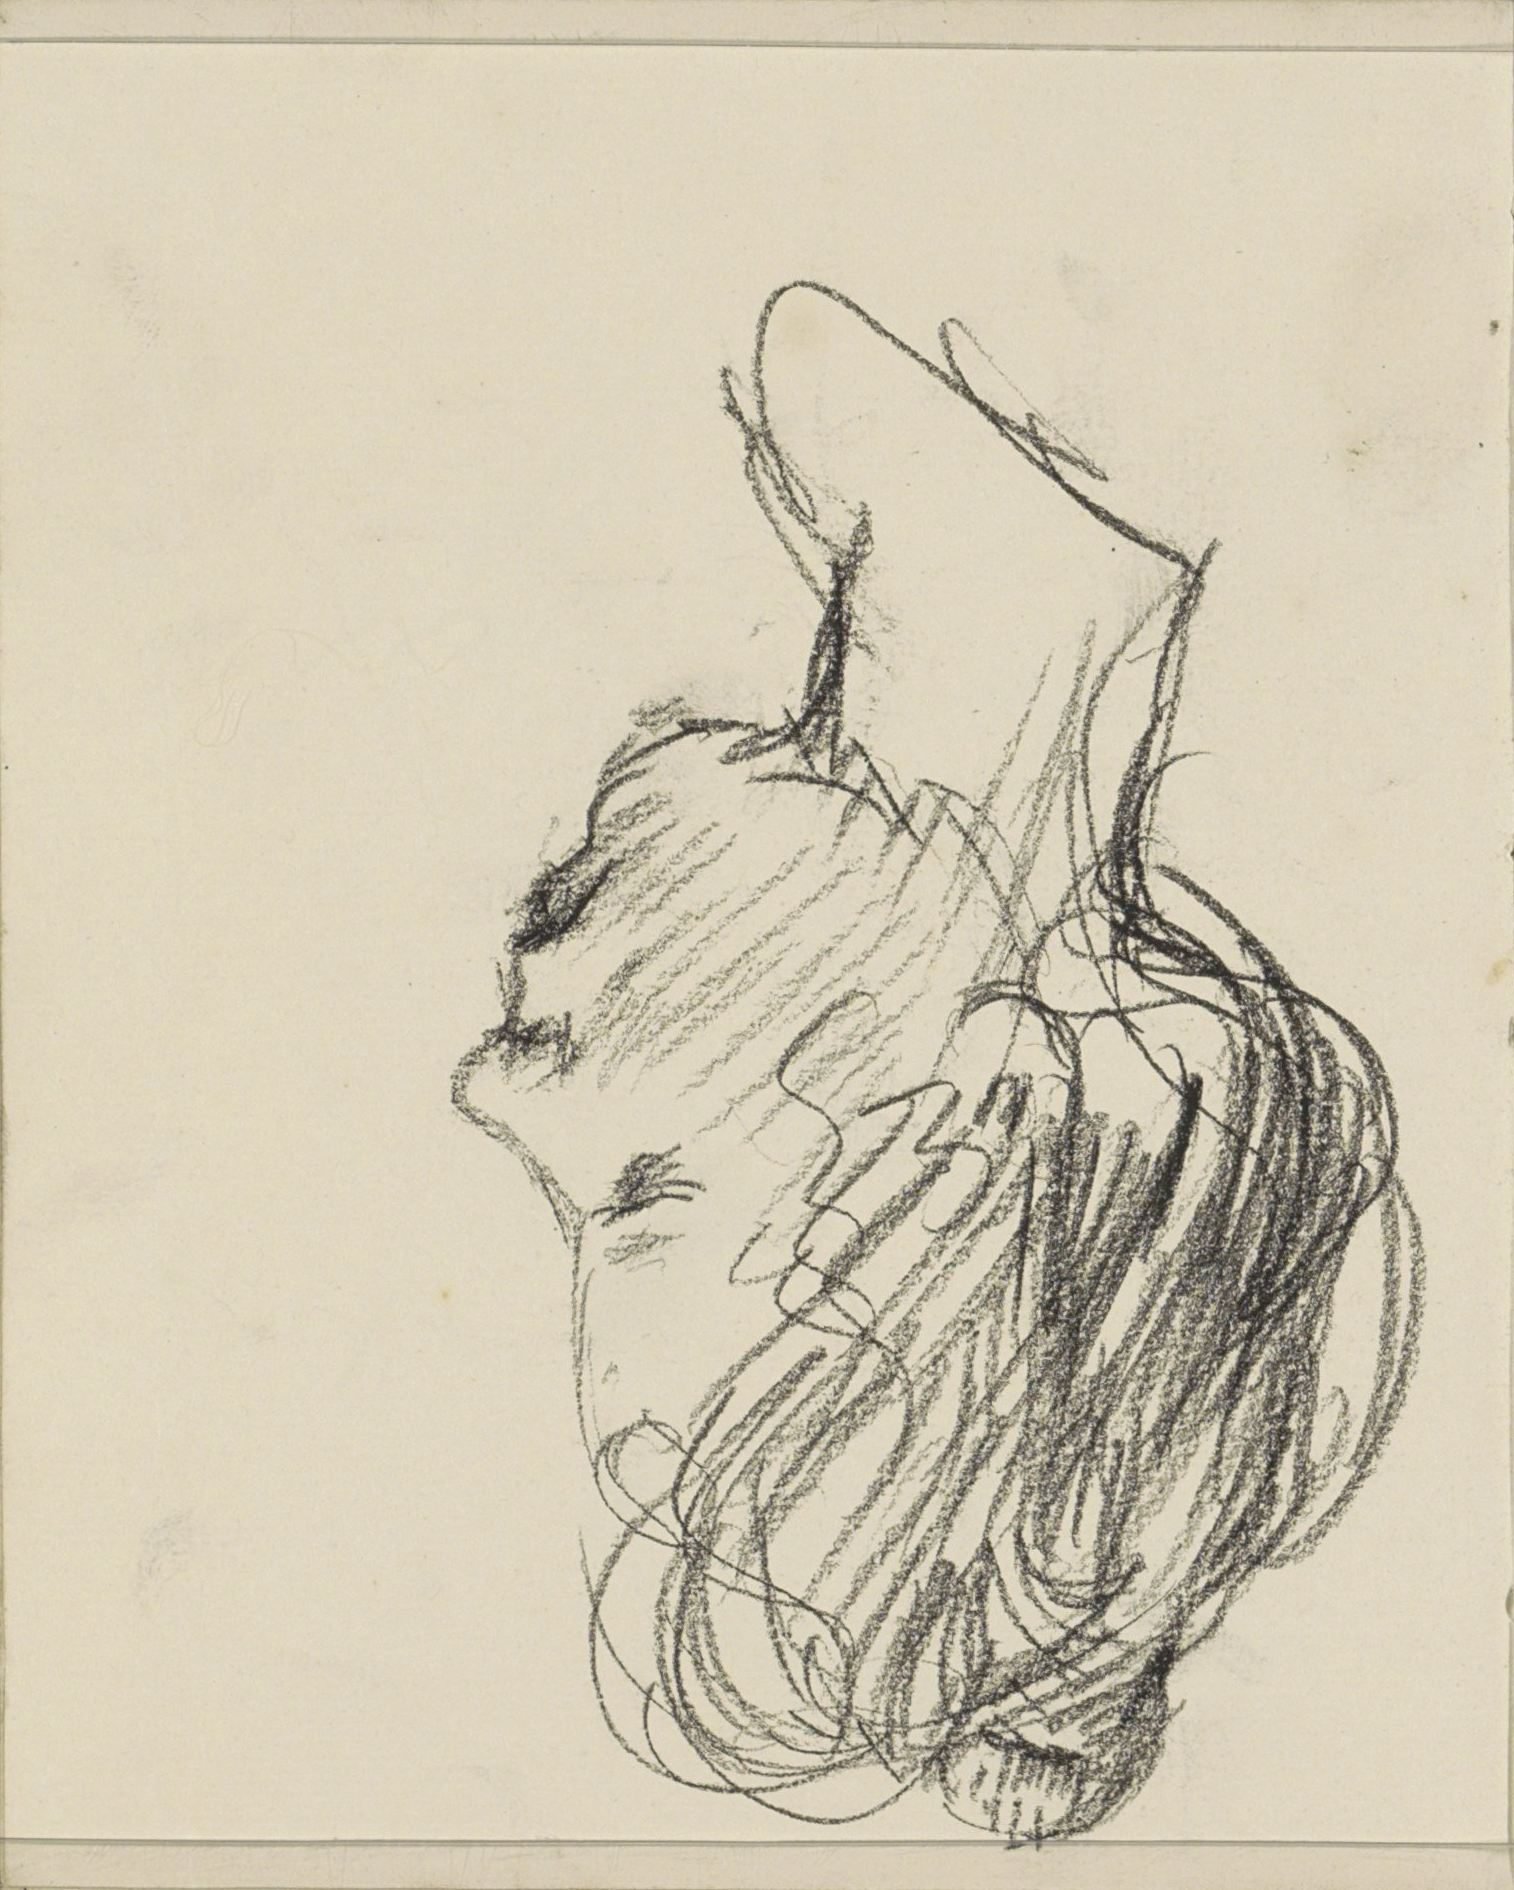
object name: sketchbook leaf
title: Vrouwenhoofd, in profiel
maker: isaac israels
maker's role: draughtsman, painter, print maker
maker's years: 1865-1934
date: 1886-1903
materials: chalk, paper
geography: amsterdam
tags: head (human) - aa - female human figure (+ sideview, profile)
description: Pagina 52 uit schetsboek XXXII met 92 pagina's.